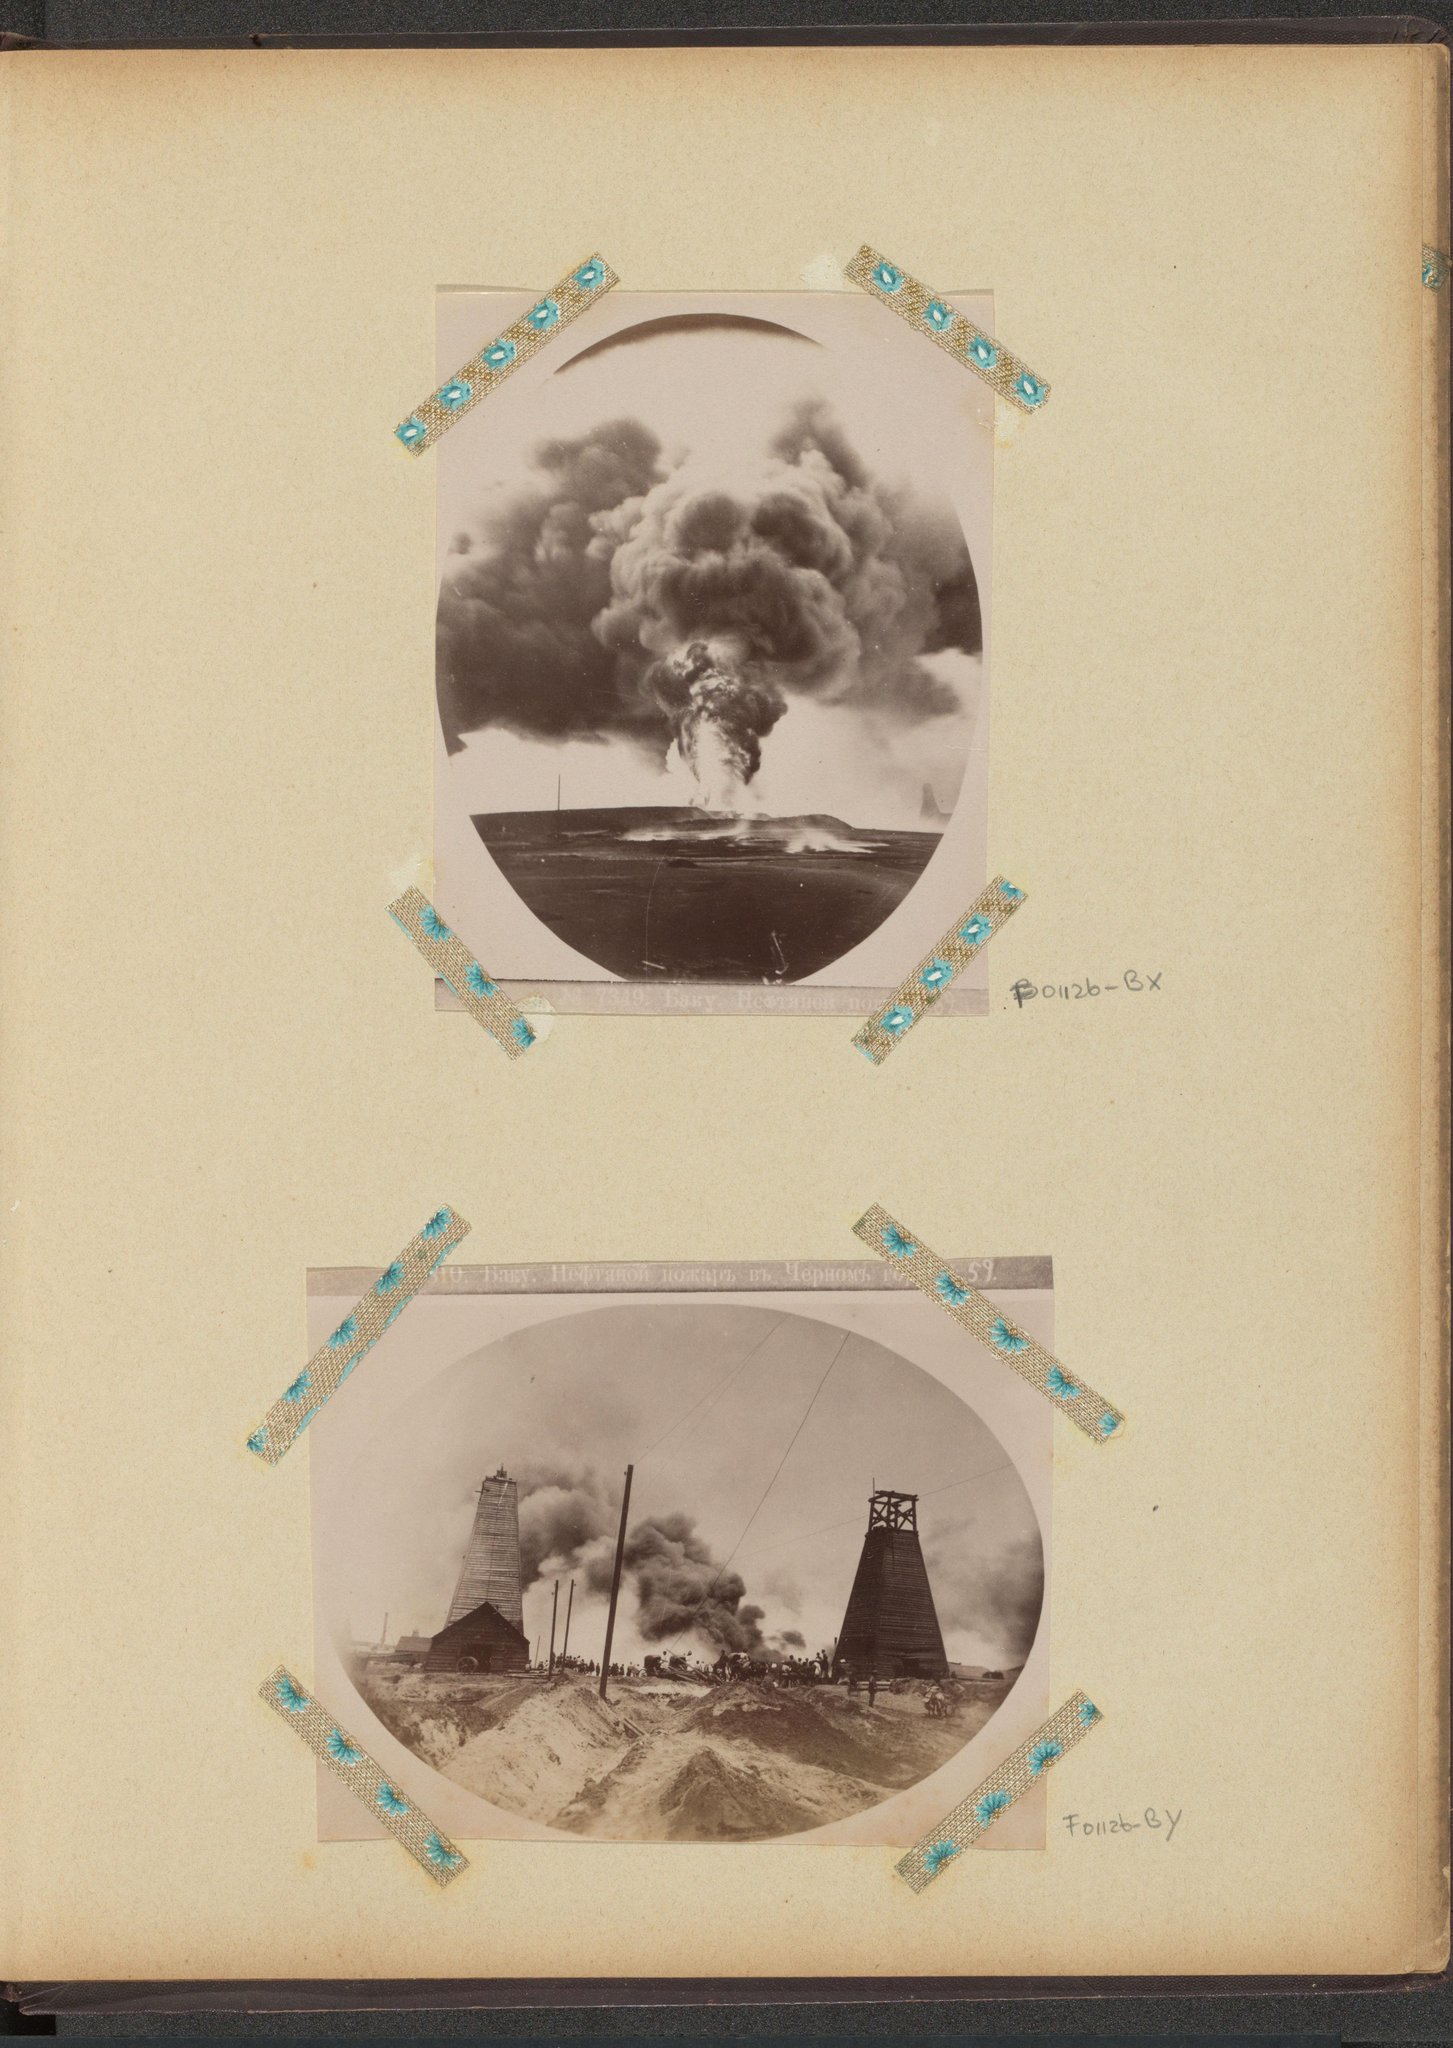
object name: photograph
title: Bakoe. Njoftjanja fontan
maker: Anonymous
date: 1890-1900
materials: photographic support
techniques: albumen print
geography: baku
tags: smoke, derrick ~ oil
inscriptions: number: ‘69’, number: ‘7349’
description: Onderdeel van Fotoalbum met opnames van bezienswaardigheden in Georgië, Sint-Petersburg en Moskou.